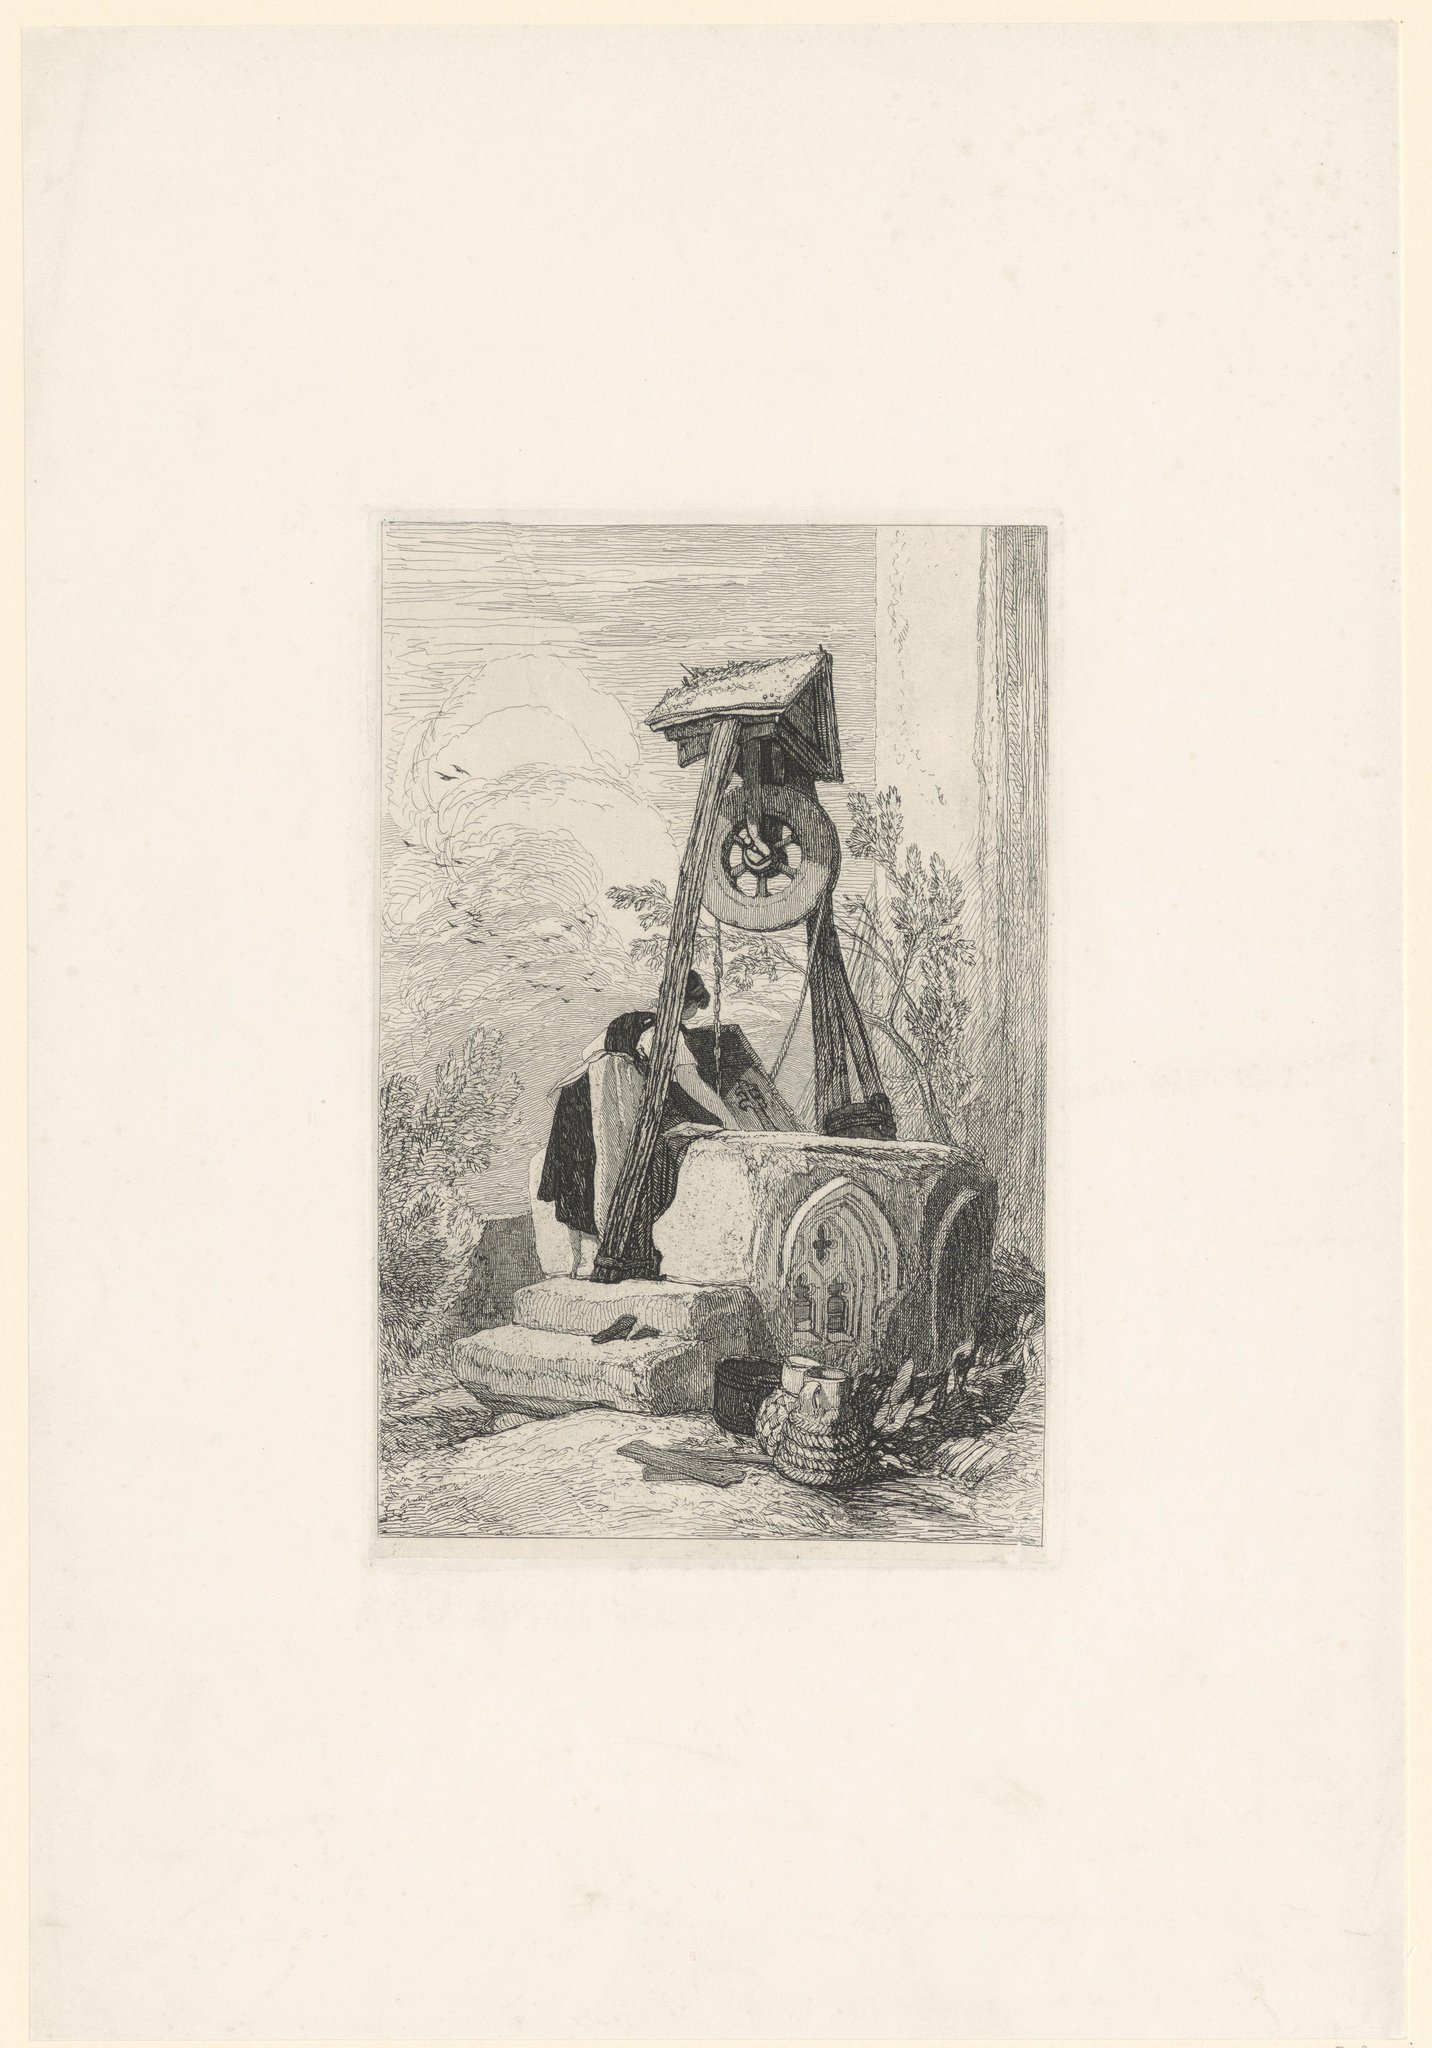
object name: print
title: Vrouw haalt water uit een put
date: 1792-1842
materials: paper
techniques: etching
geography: norwich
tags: well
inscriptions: collector's mark: Lugt 2760, collector's mark: Lugt 2228